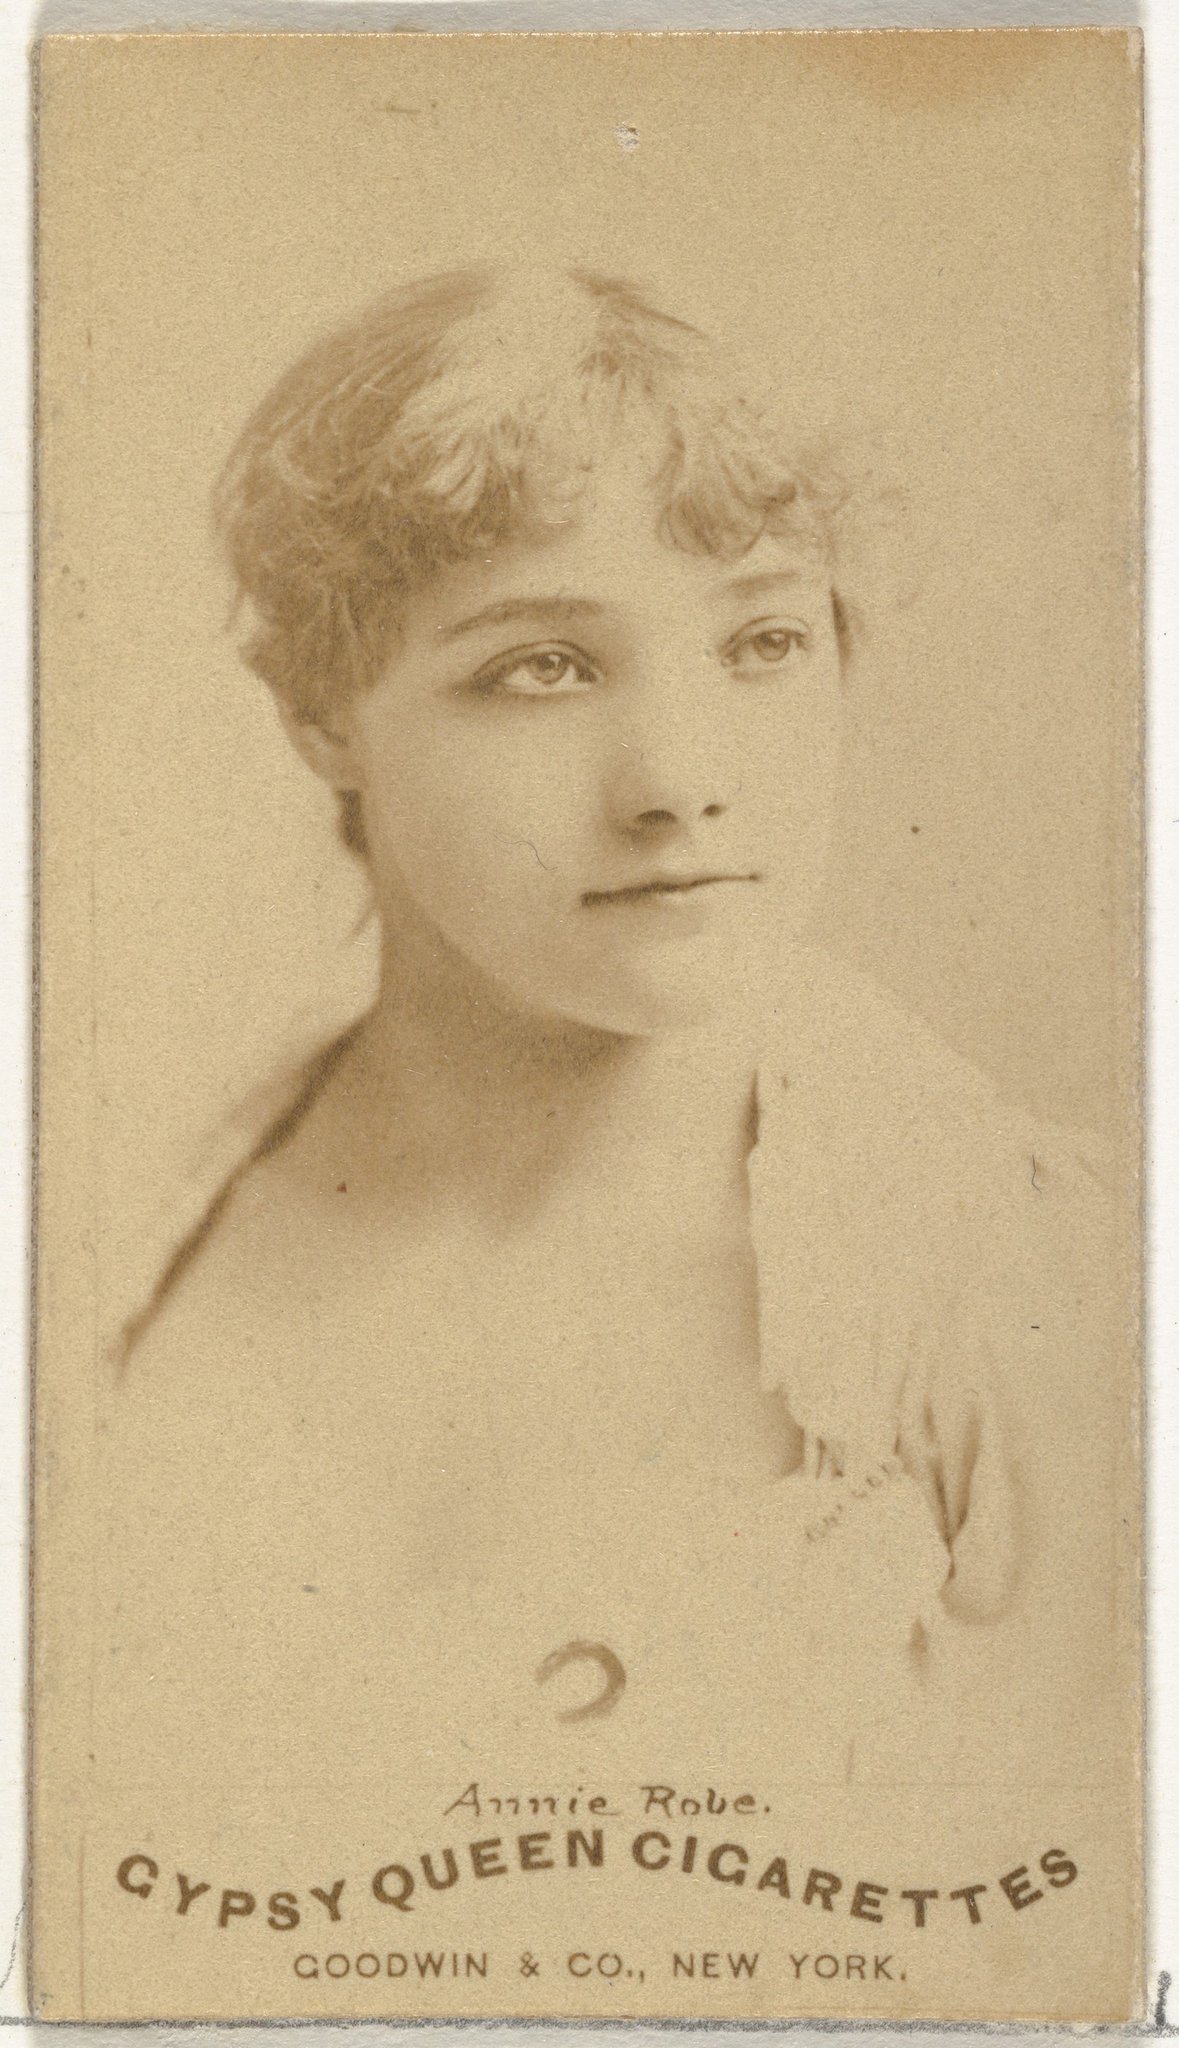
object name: photograph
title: Annie Robe, from the Actors and Actresses series (N171) for Gypsy Queen Cigarettes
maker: goodwin & company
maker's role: publisher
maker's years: 1850-1950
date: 1886-1890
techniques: albumen silver print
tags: portraits,women,actresses